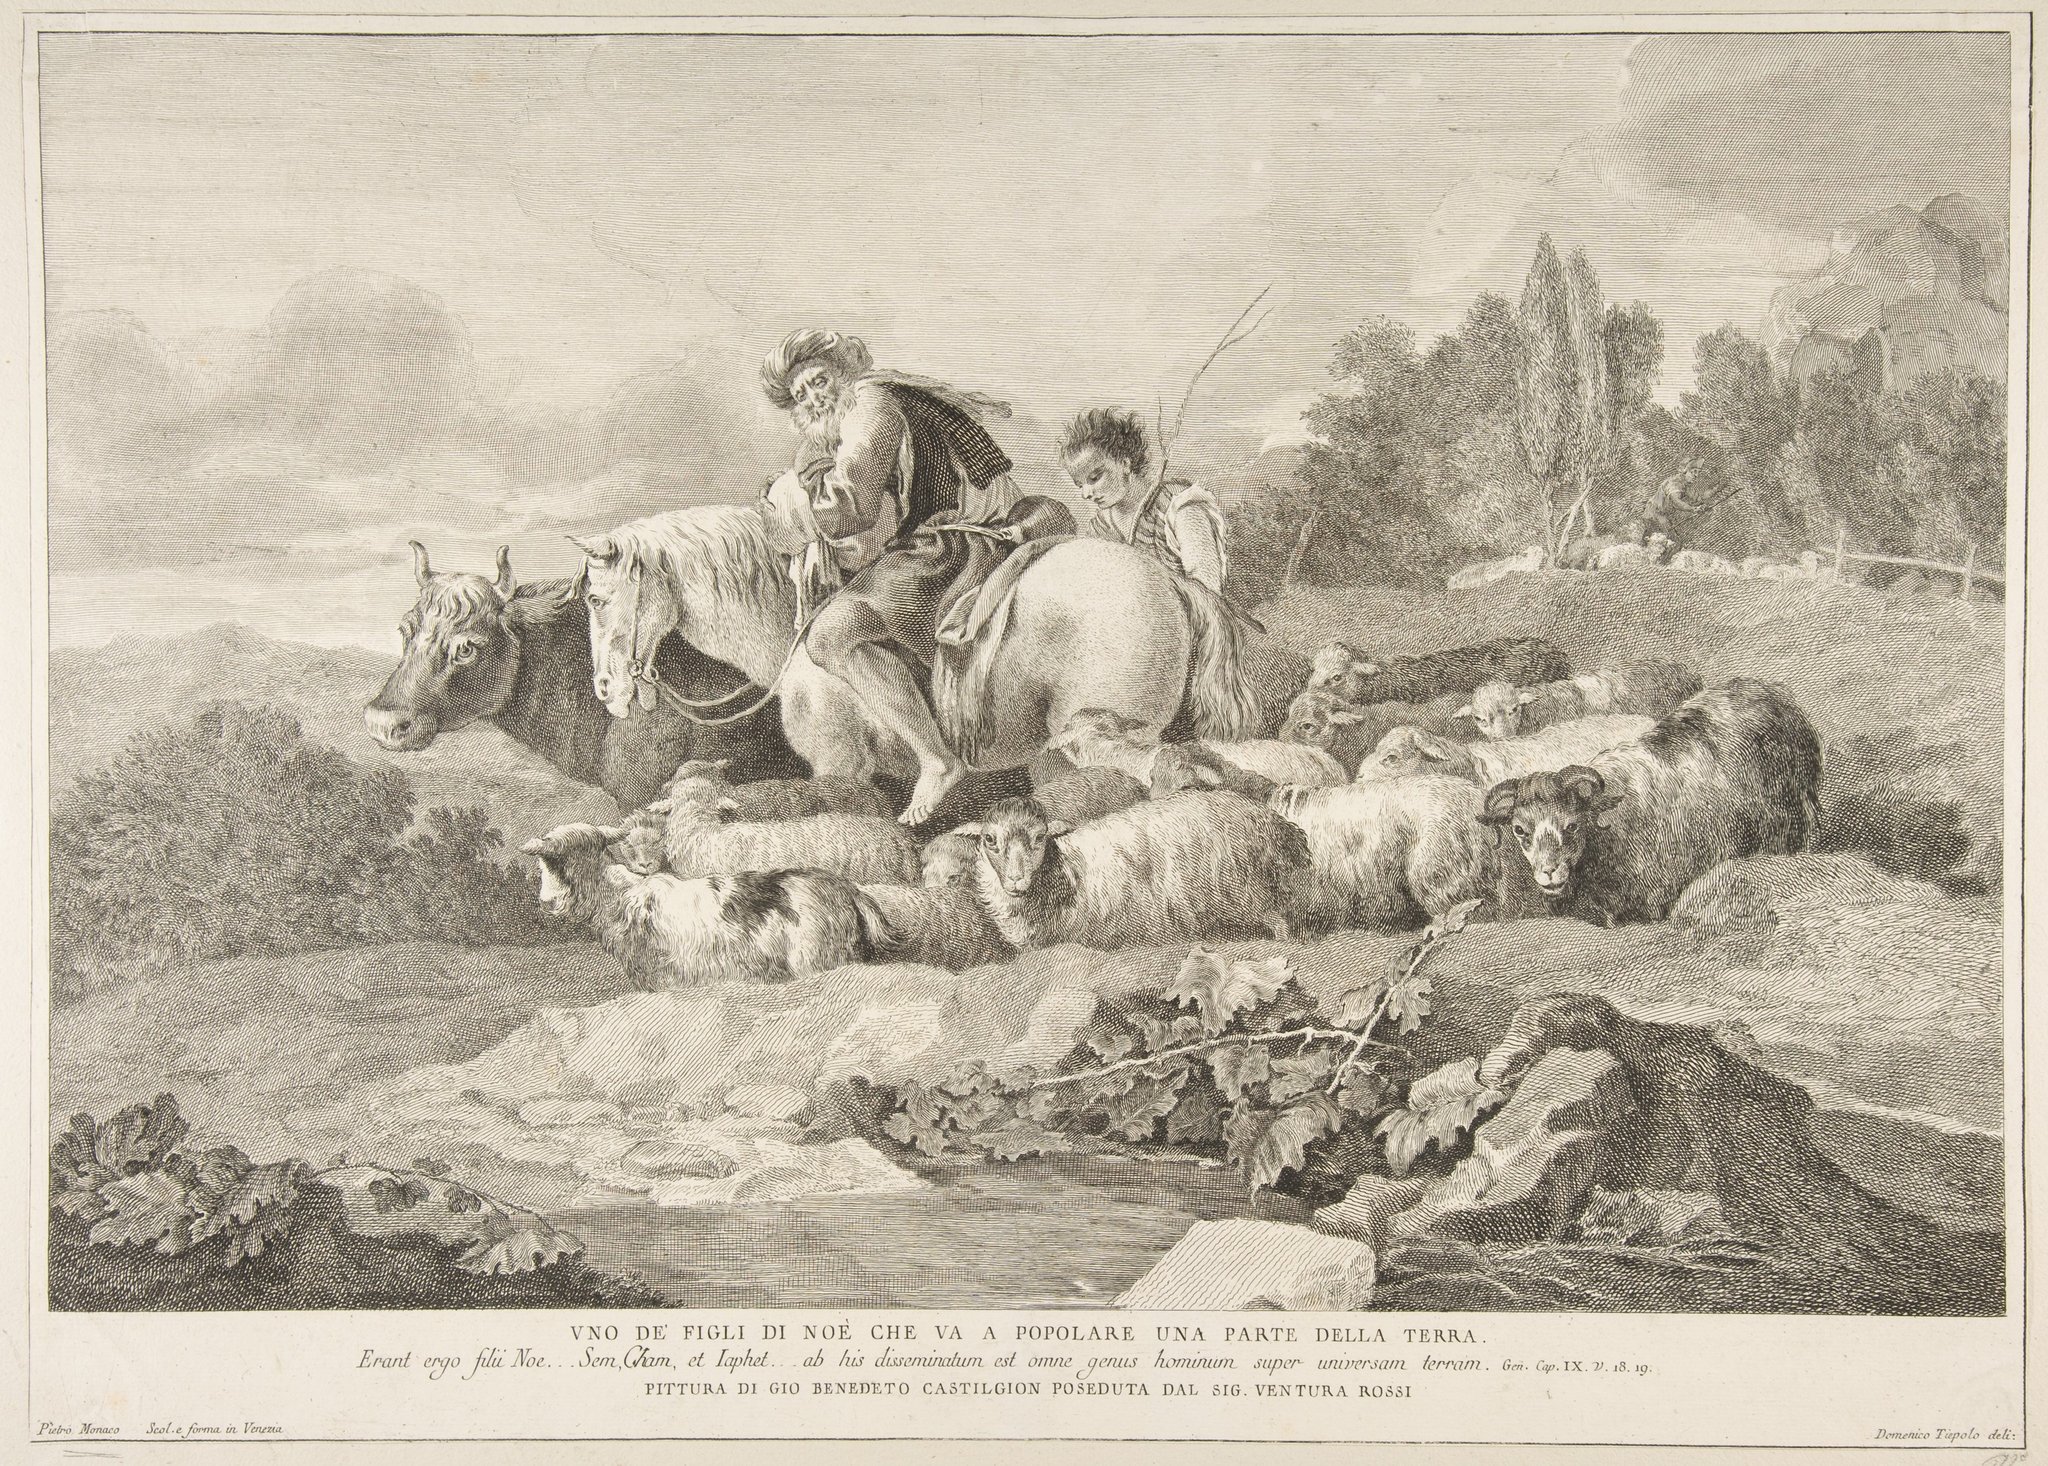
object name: print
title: One of the Sons of Noah who Goes to Populate a Part of the Earth (Uno de figli di Noè che va a popolare una parte della terra)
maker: pietro monaco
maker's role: artist and publisher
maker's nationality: italian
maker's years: 1707-1772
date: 1743-1763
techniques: etching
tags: men,cows,horses,sheep,landscapes